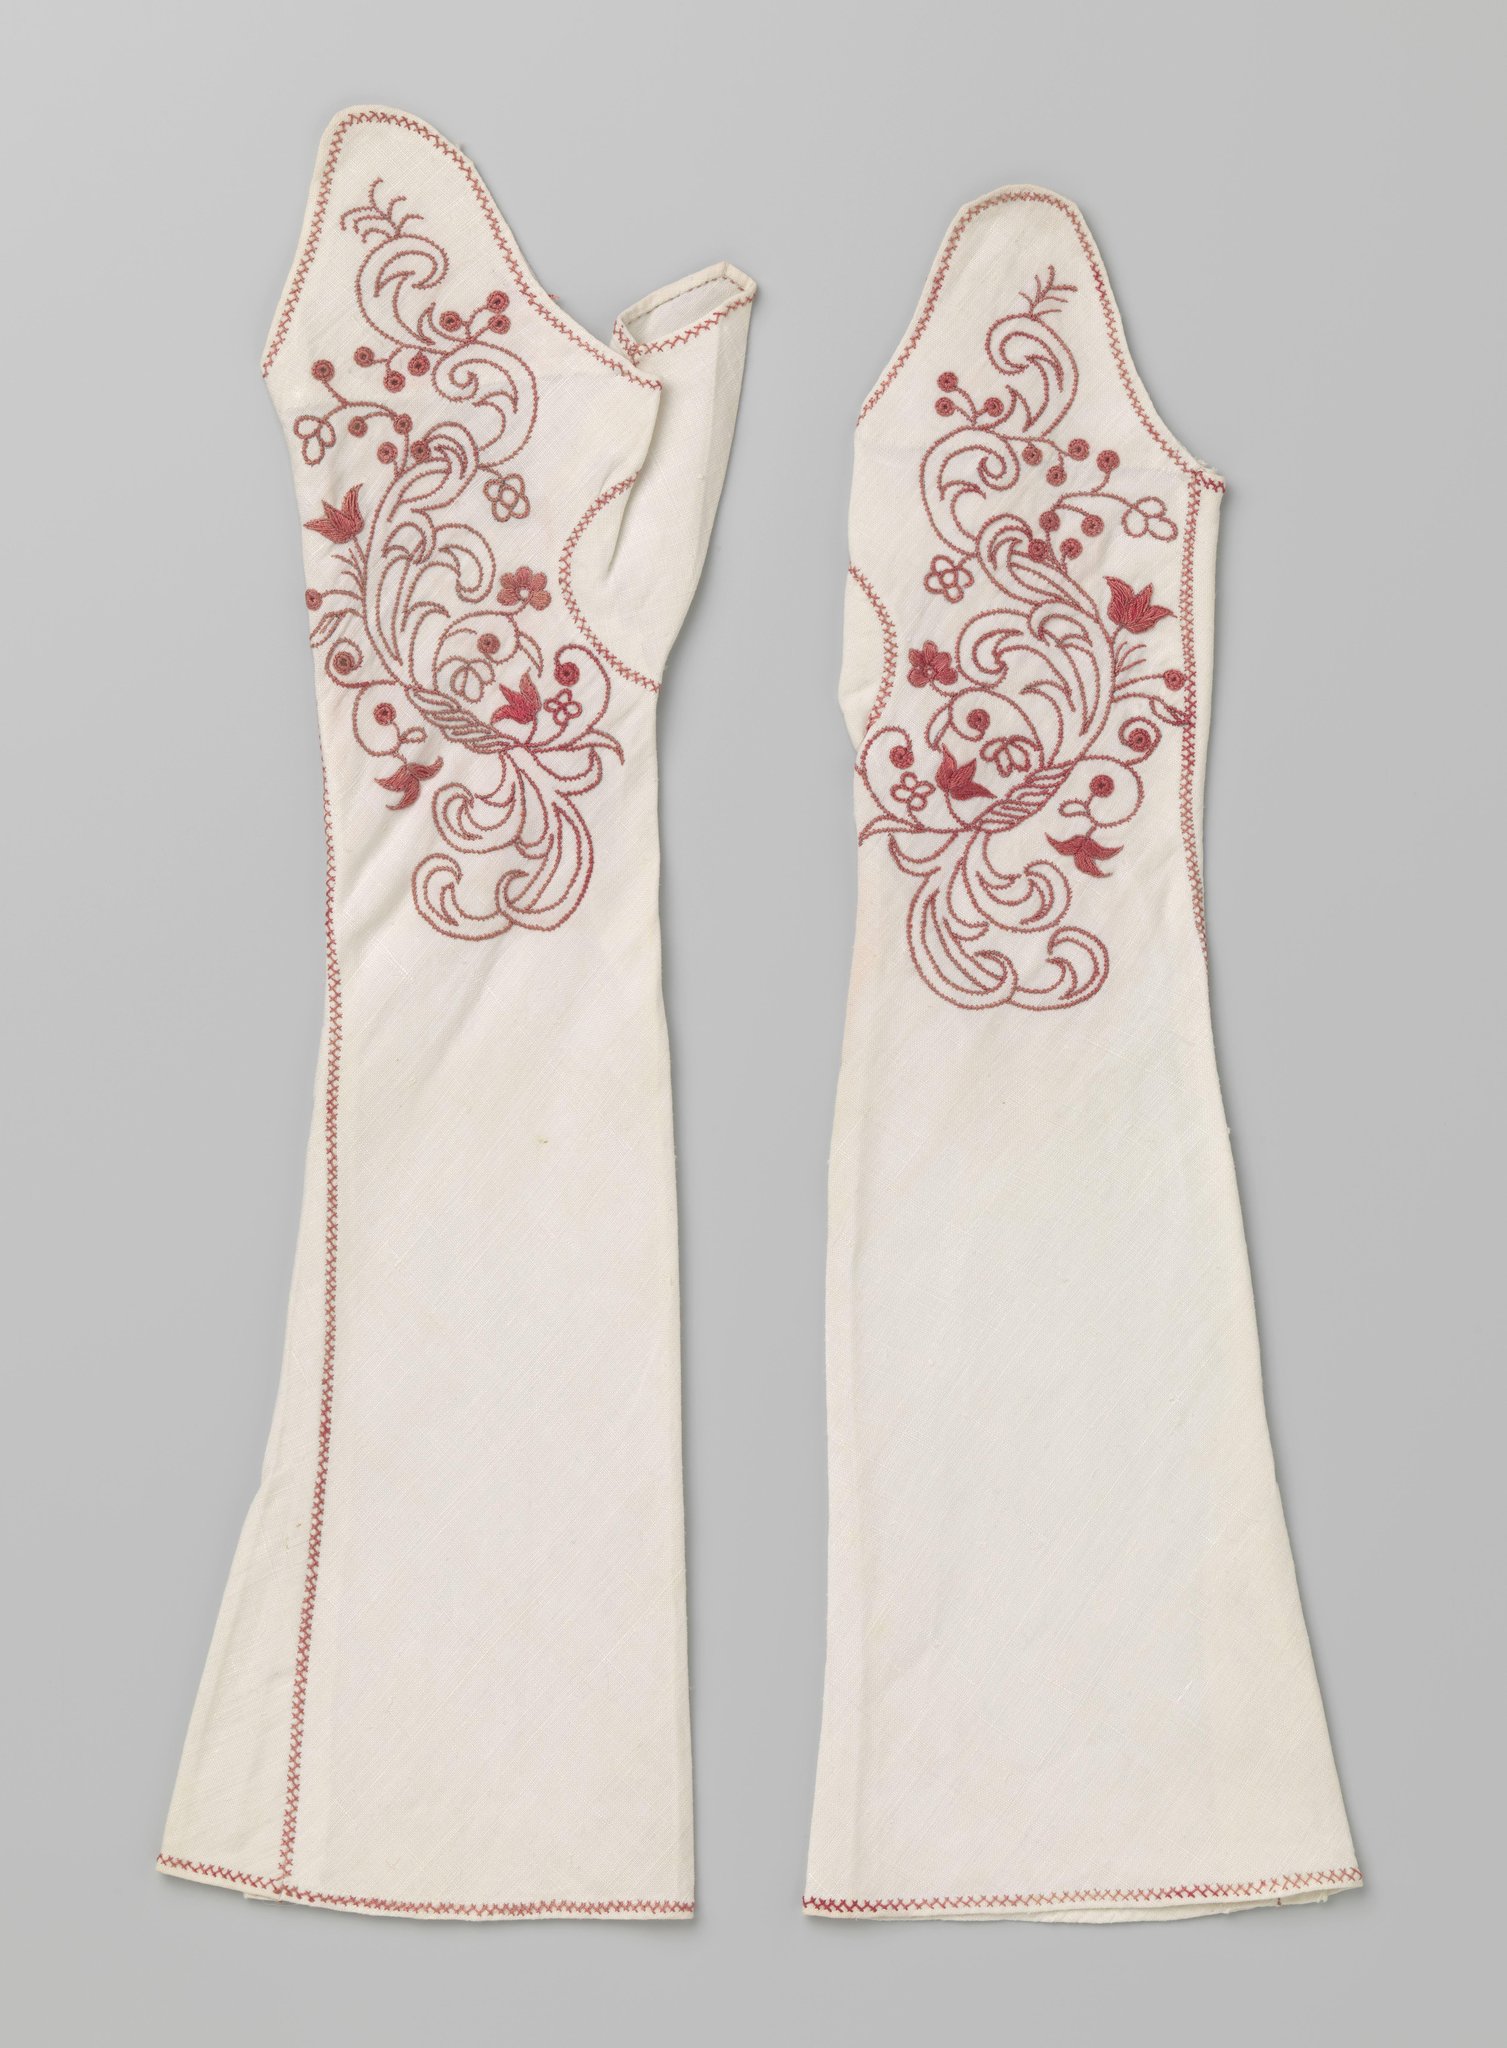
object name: glove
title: Mitaine van witte keperkatoen en linnen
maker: Anonymous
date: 1750-1800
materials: cotton, linen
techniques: weave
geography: northern netherlands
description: Paar lange mitaines van keperkatoen en linnen. werk. Schuin uit de stof geknipt. Gevoerde punt die over de handrug valt. Ingezette duim zonder top. Rood borduurwerk. Groot vlak over de handrug , pols en onderarm versierd met een rokoko van een opgelegd koordje gemaakte tak, die dubbel S-vormig gezwenkt is met uitlopers. De tak is in ongevulde contouren aangegeven. Kleine zijhechtrankjes eindigen in een tulpje, rozetjes en besjes.